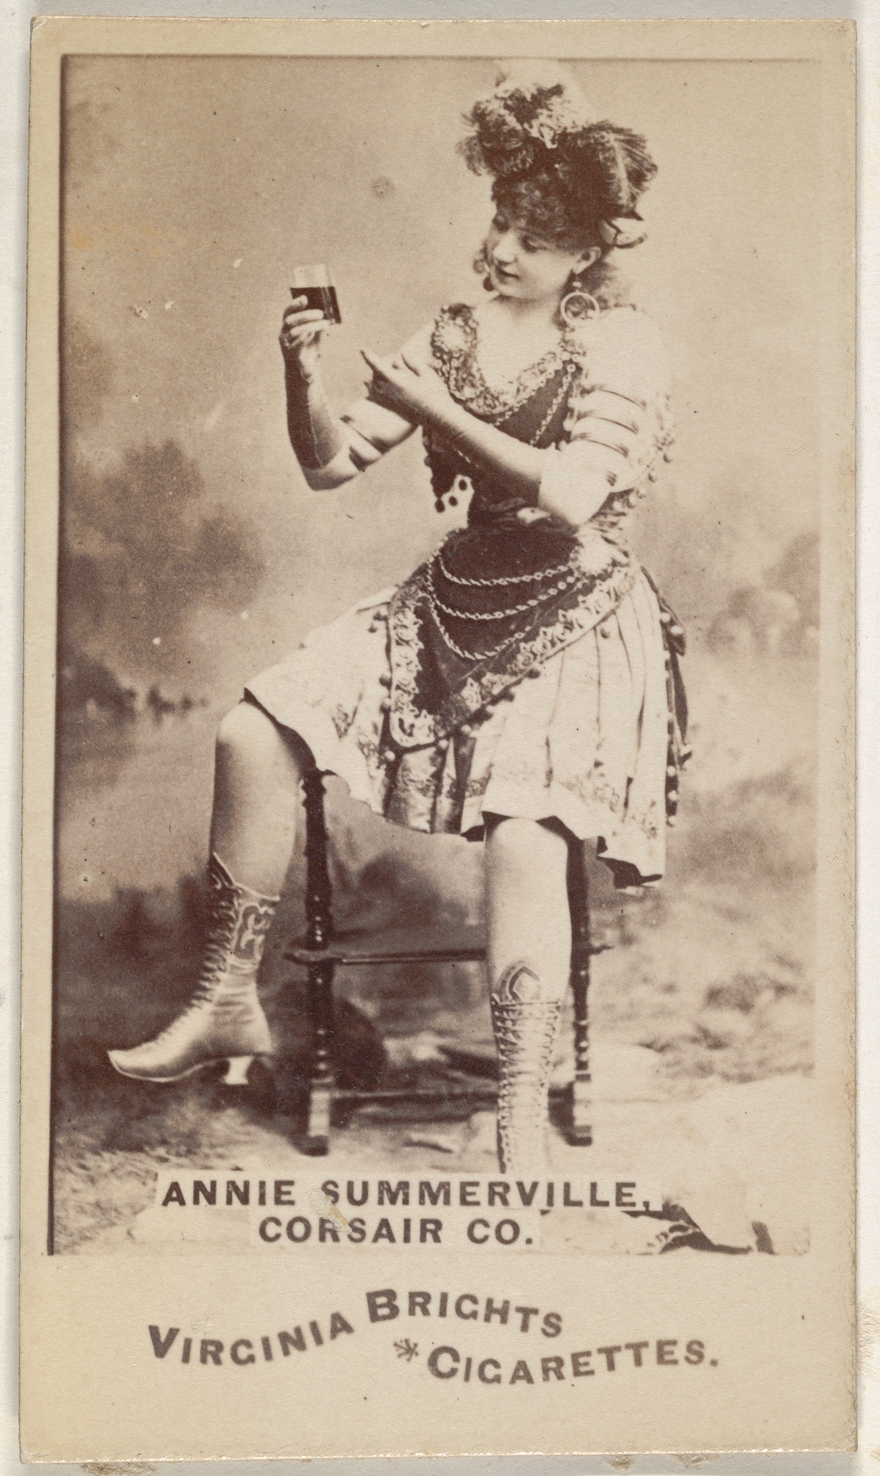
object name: photograph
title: Annie Summerville, Corsair Co., from the Actors and Actresses series (N45, Type 6) for Virginia Brights Cigarettes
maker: allen & ginter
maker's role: publisher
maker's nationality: american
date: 1888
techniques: albumen silver print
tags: portraits,women,actresses